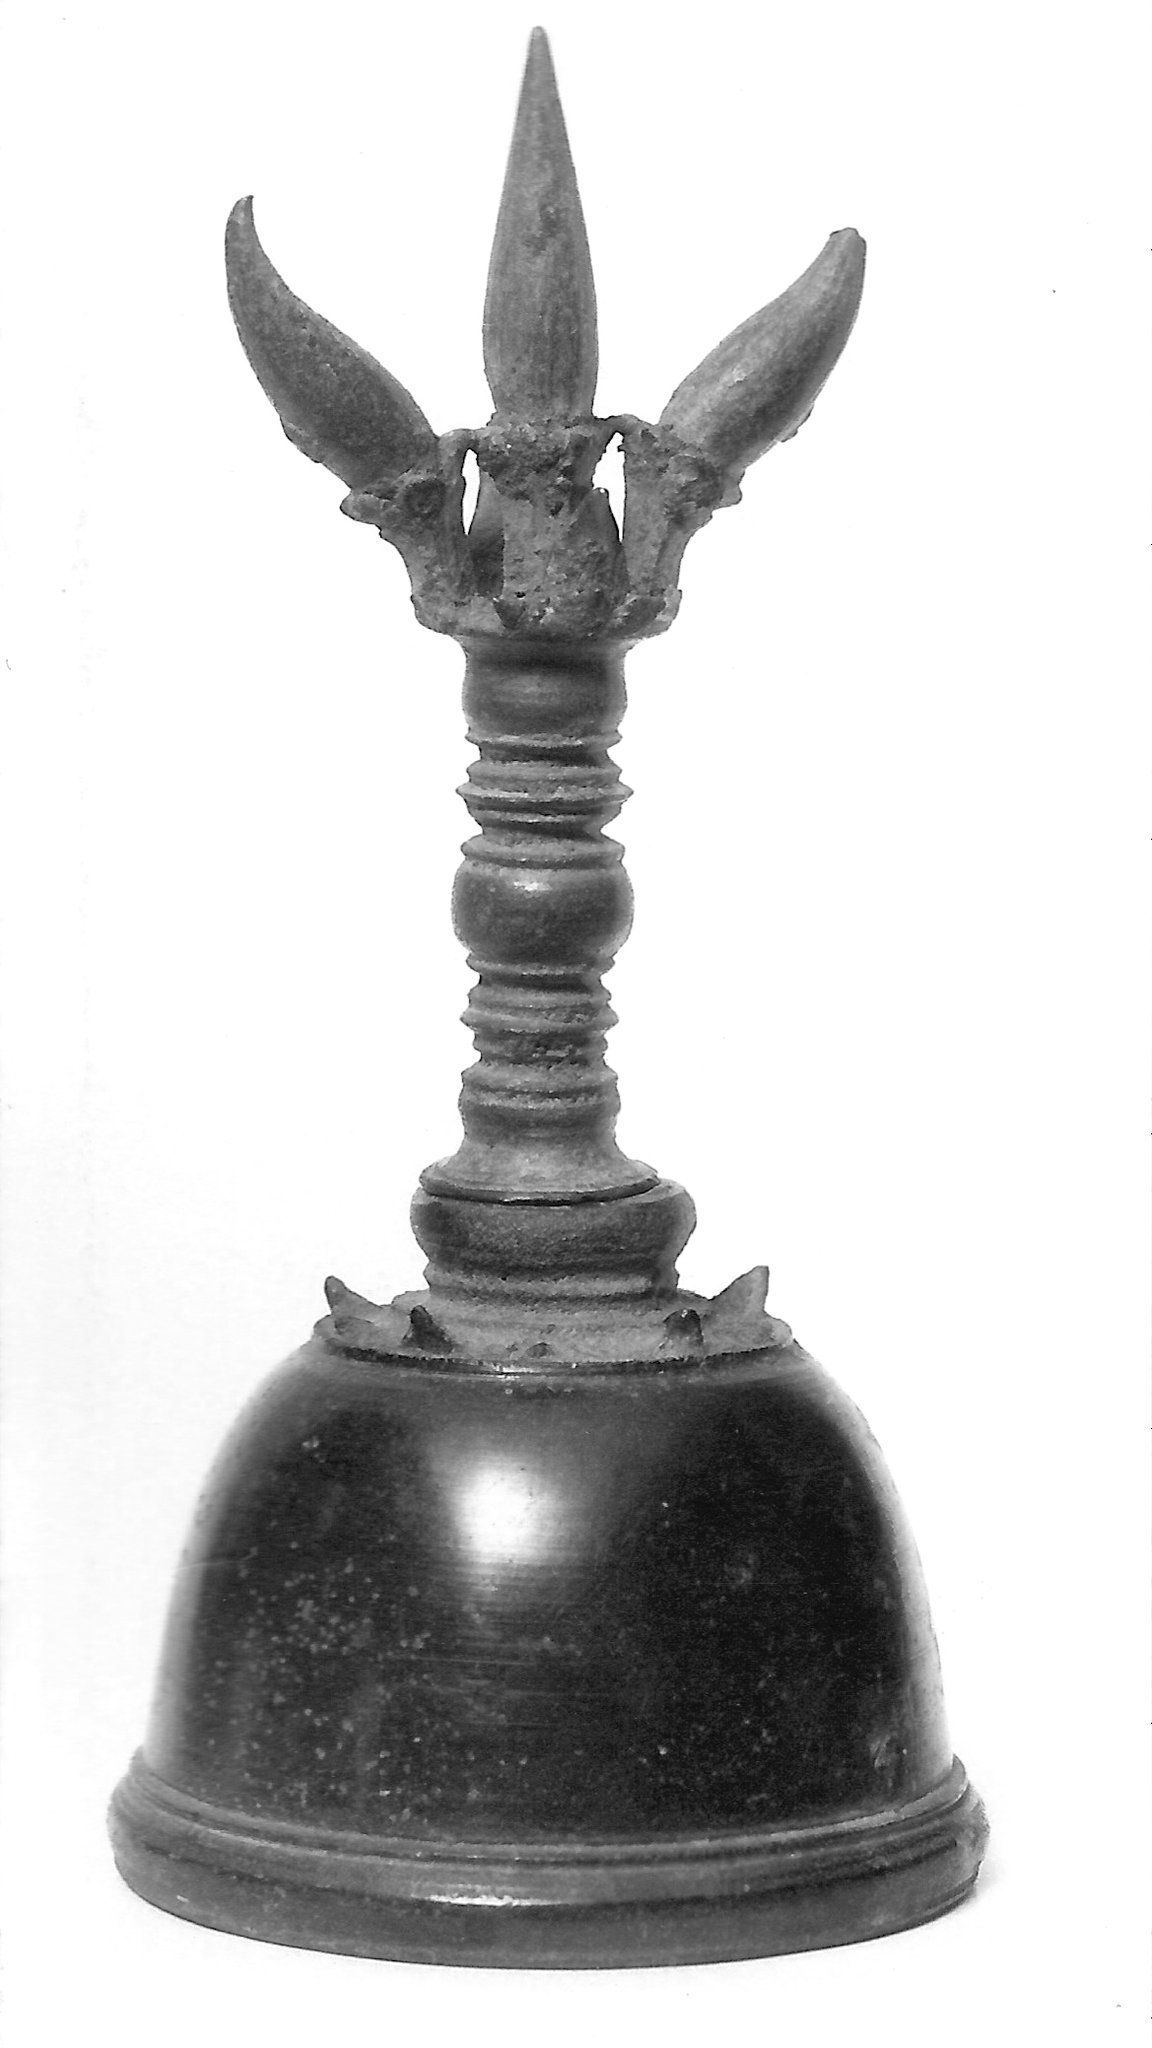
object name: gheṇṭa prayer bell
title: Gheṇṭa (prayer bell)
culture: javanese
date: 1001-1100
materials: bronze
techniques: casting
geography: indonesia